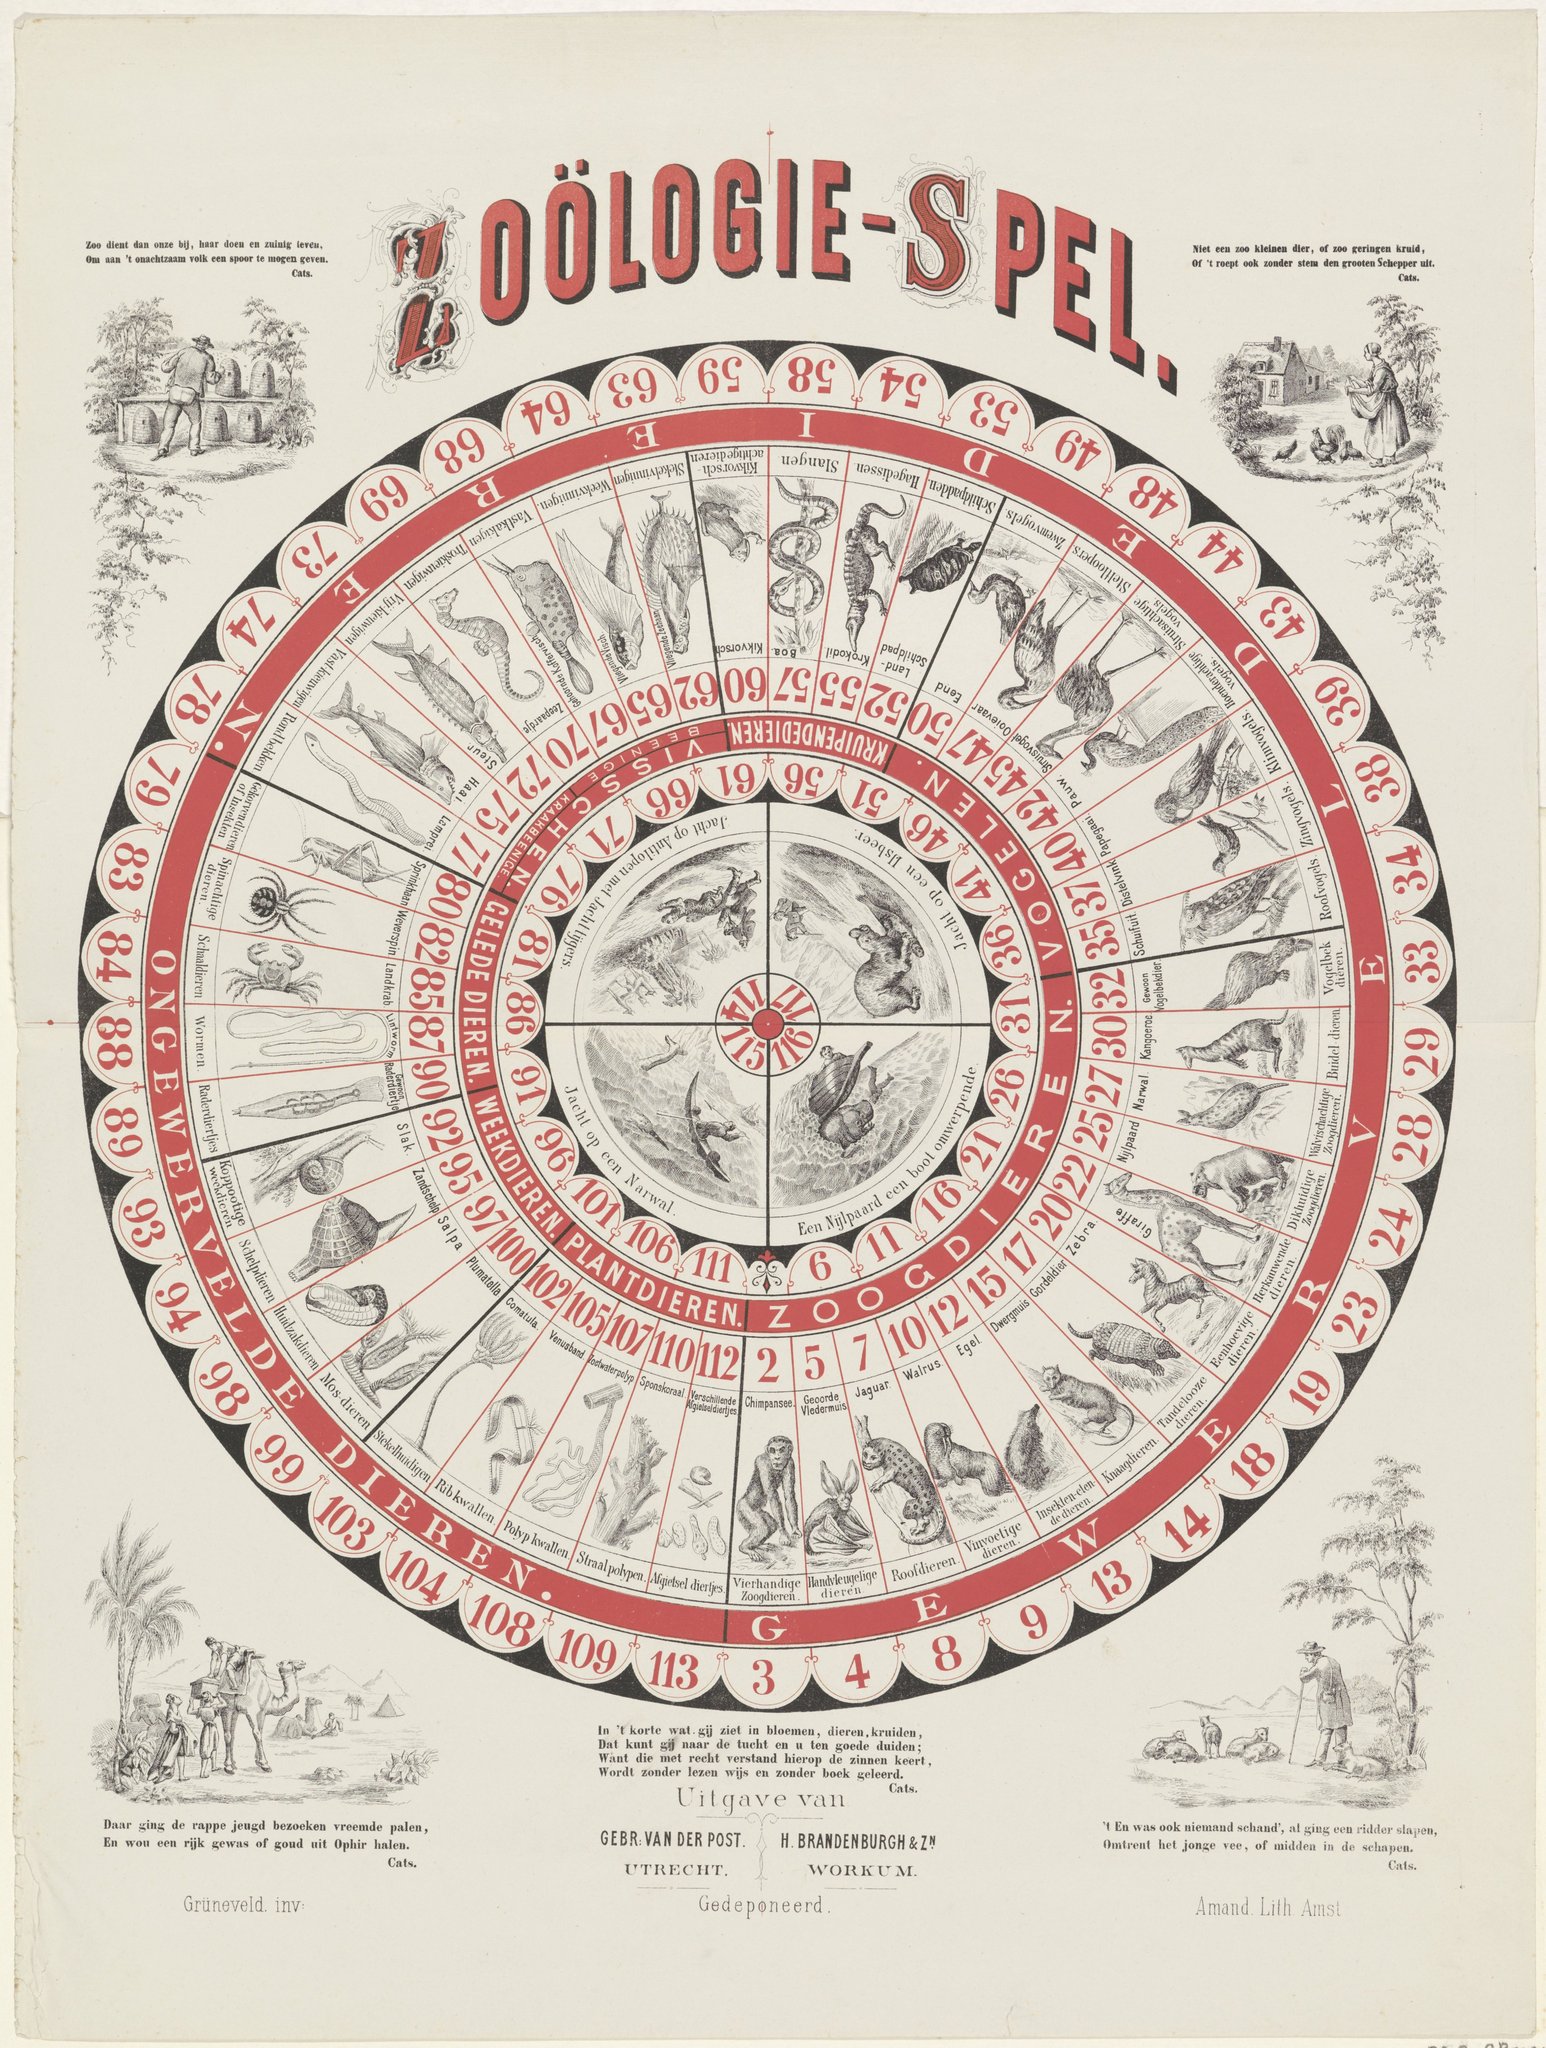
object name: popular print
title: Zoölogie-spel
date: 1875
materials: paper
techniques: lithograph, letterpress printing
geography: utrecht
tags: animals, board-games of chance, hunt ~ mammals, board-games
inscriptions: collector's mark: Lugt 2760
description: Spel in de vorm van een cirkel met genummerde vankjes van 2 tot en met 117, met gewervelde en ongewervelde dieren. Op het middenveld vier jachttaferelen. In de hoeken rond de cirkel afbeeldingen met dichtregels van Cats.